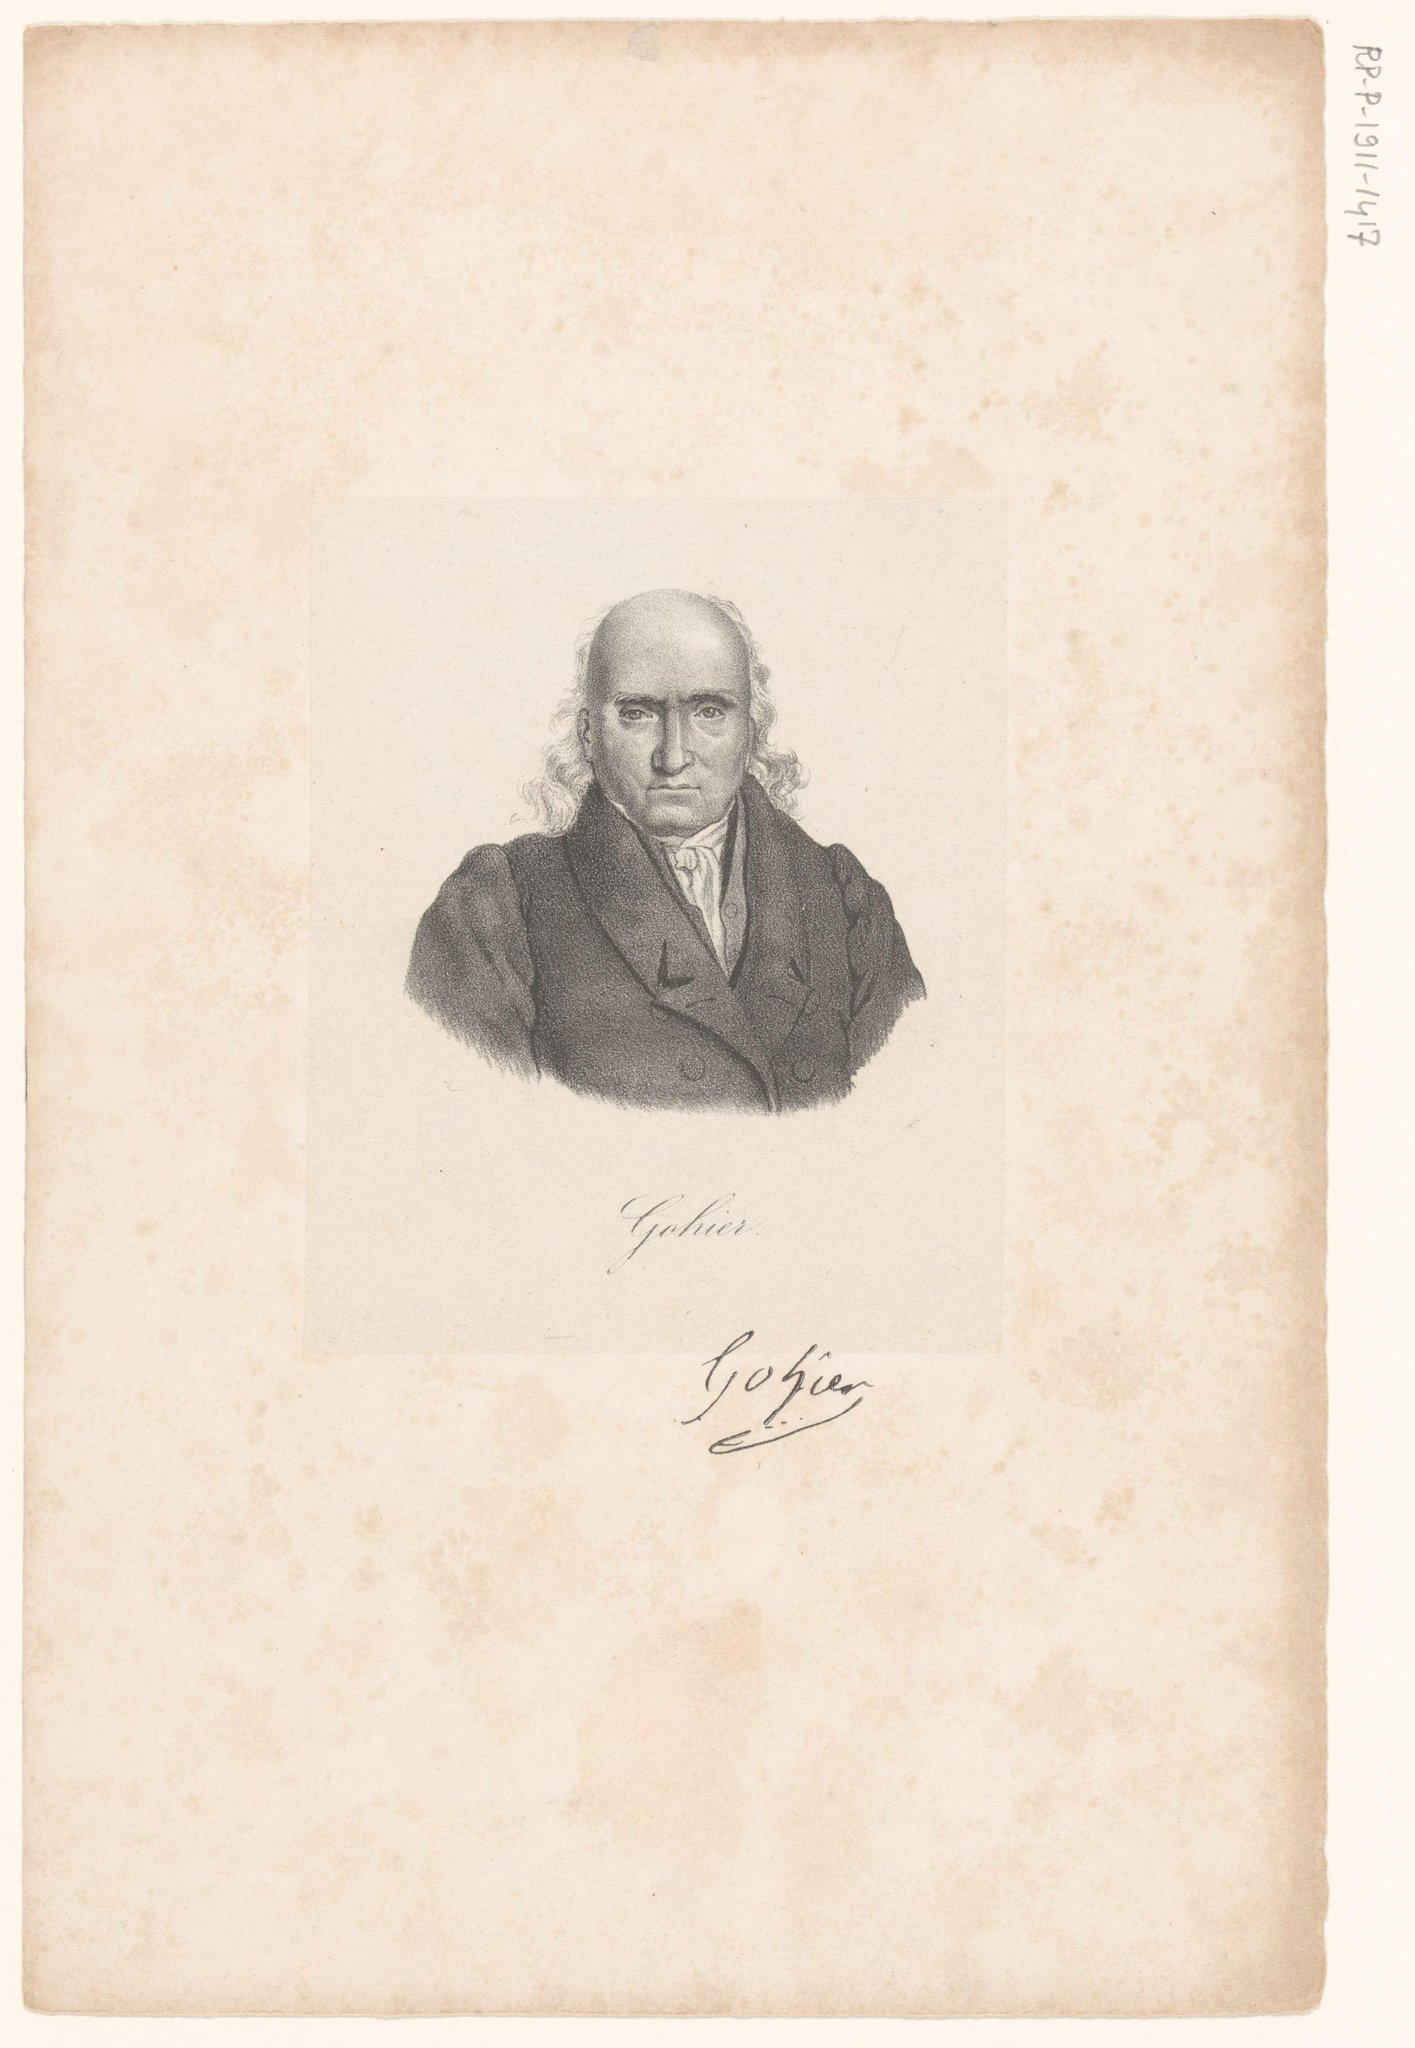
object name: print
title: Gohier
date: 1818-1842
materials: paper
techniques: lithograph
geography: paris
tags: politician, historical persons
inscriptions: collector's mark: Lugt 2228a